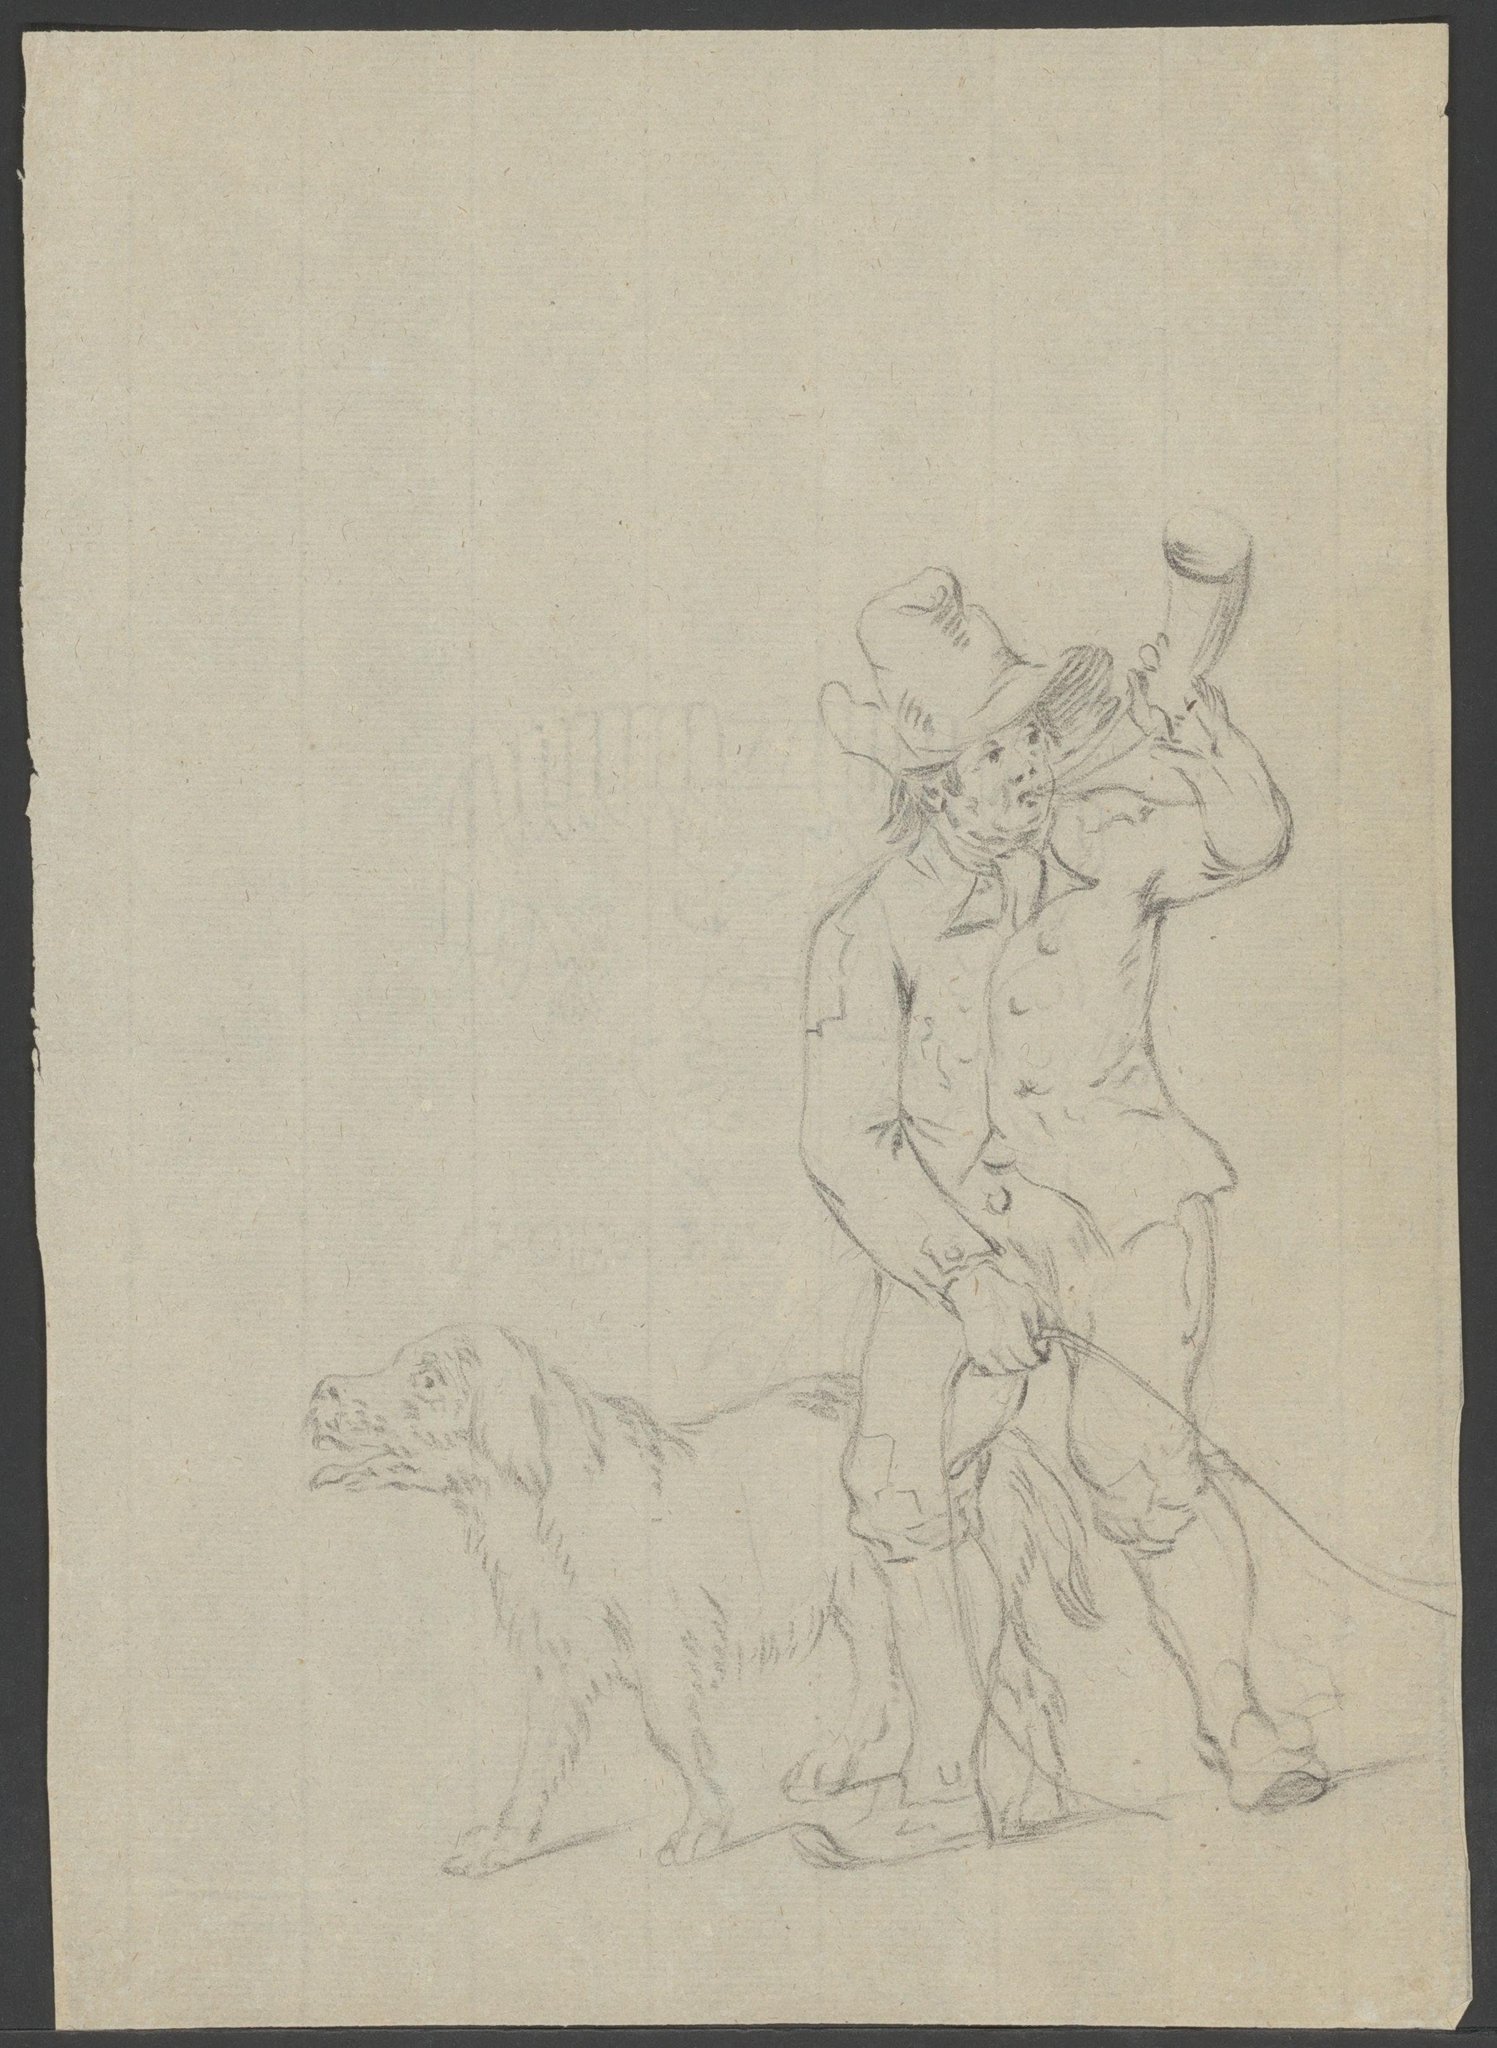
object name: drawing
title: Man met hond blaast op zijn hoorn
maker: Anonymous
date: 1800-1899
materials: chalk, paper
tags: blowing the hunting horn, dog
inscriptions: stamp, collector's mark: Lugt 1641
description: Man met hond blaast op zijn hoorn. Zijn kleding is op verschillende plaatsen gerepareerd. Onderwerpsrubrieken binnen de Atlas Zeden en Gewoonten: Schoone kunsten, Schilderkunst, Tekeningen.